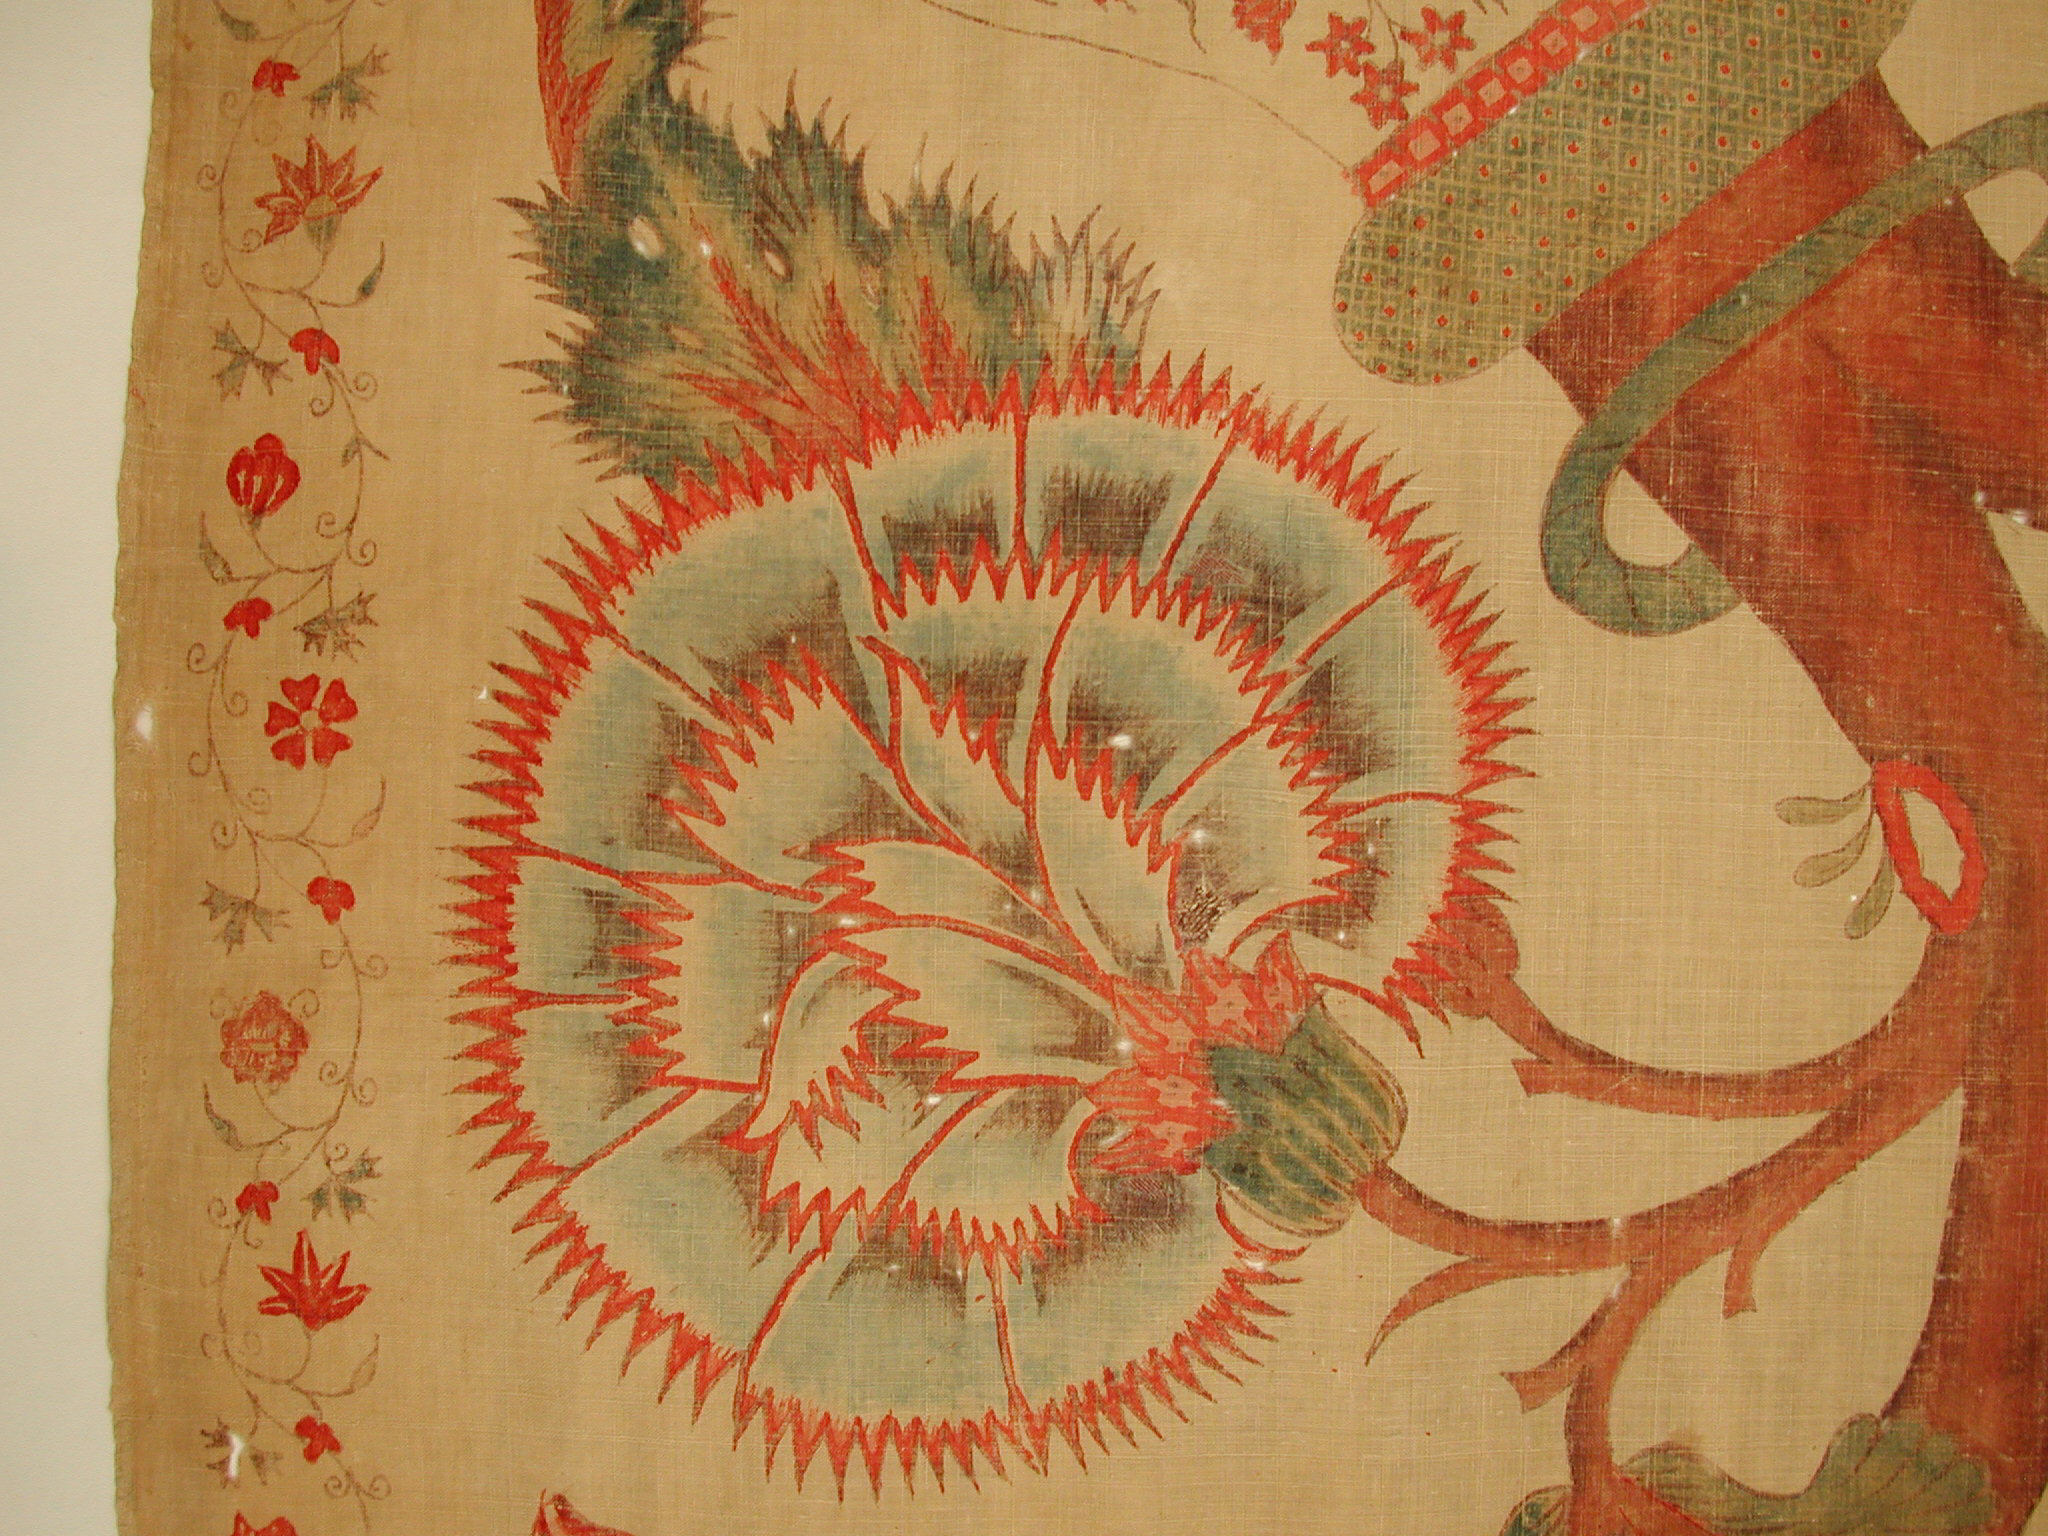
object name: hanging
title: Hanging (Palampore)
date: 1667-1700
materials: cotton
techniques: painting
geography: india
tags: flowers,trees